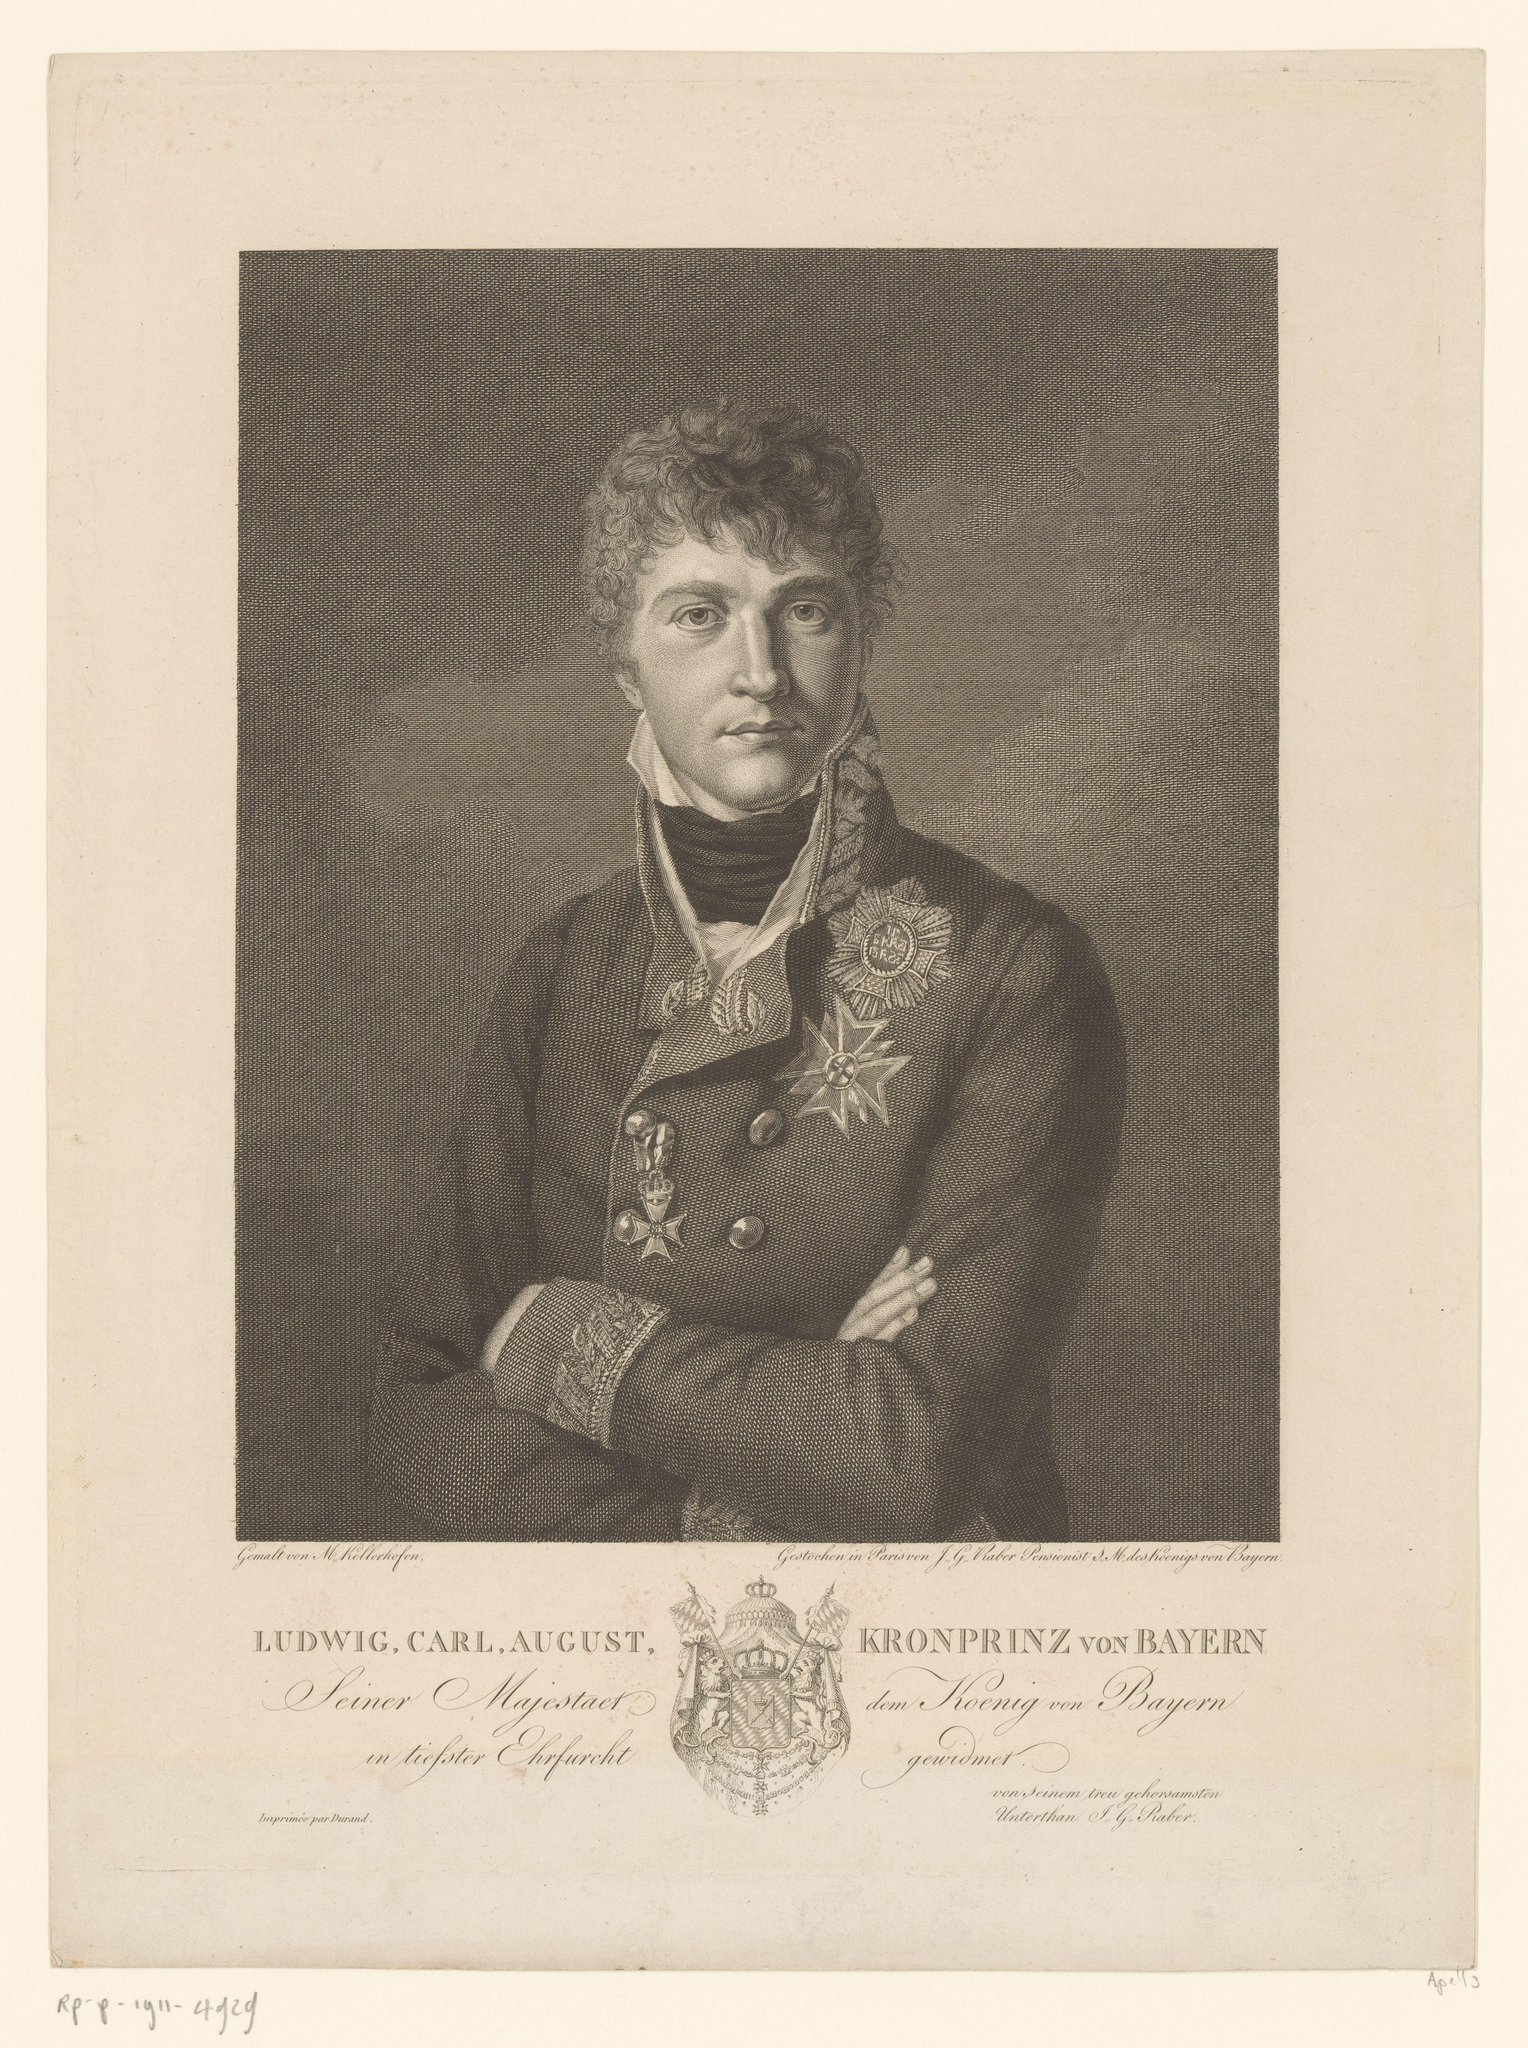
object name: print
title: Portret van Lodewijk I van Beieren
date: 1796-1830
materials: paper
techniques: engraving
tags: lodewijk i (koning van beieren), historical persons, medals and other marks of military honour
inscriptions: collector's mark: Lugt 2228